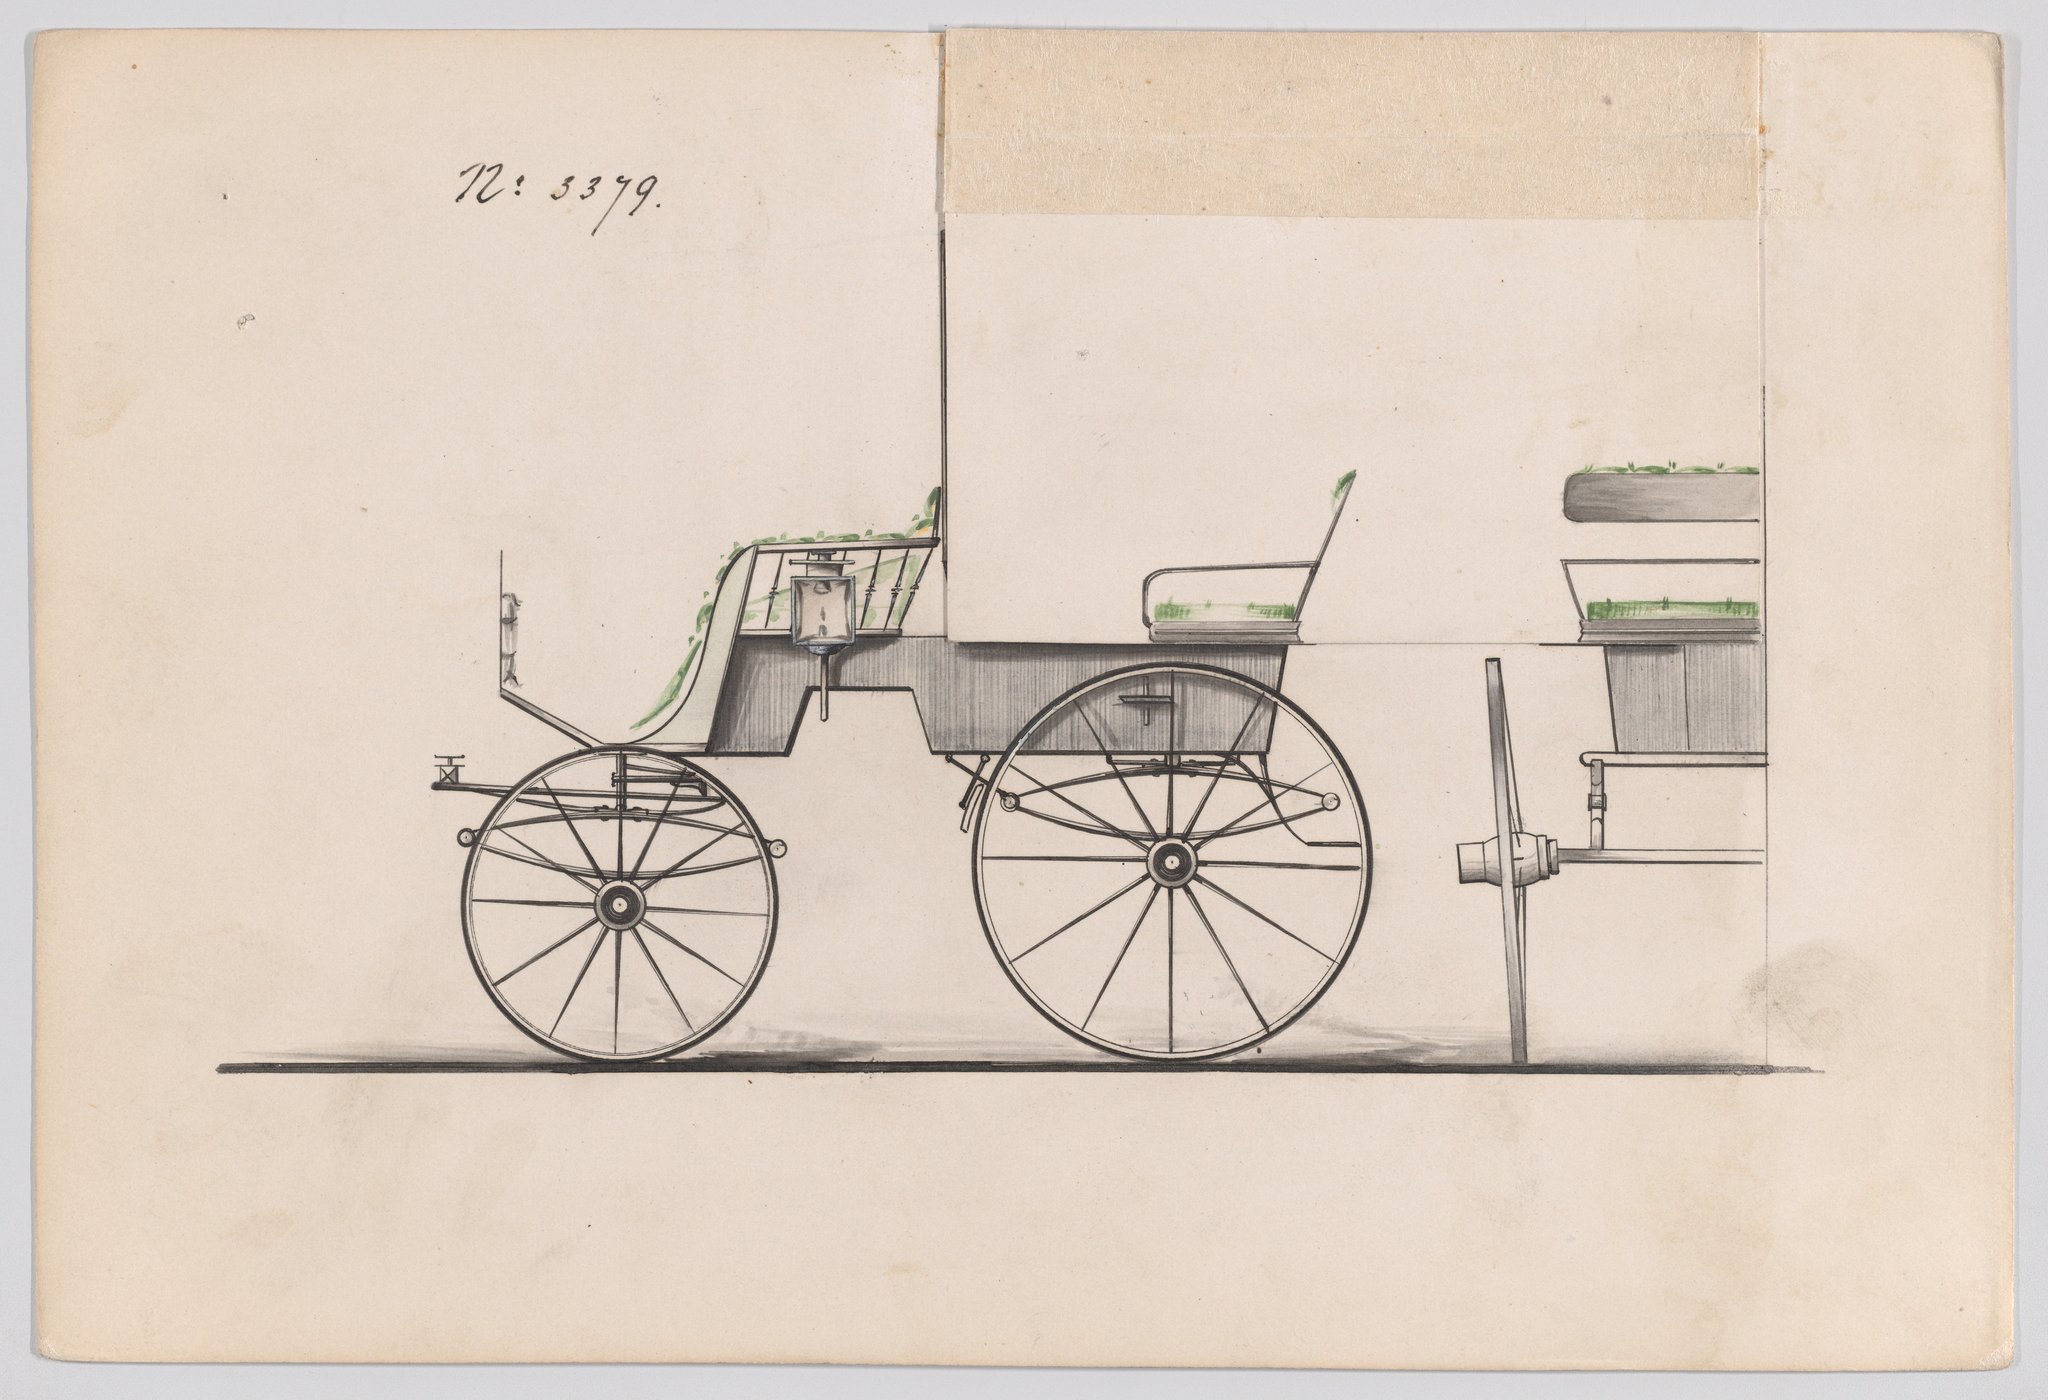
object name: drawing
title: Design for T-Cart, no. 3379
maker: brewster & co.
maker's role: manufacturer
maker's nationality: american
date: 1877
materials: ink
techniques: pen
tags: carriages